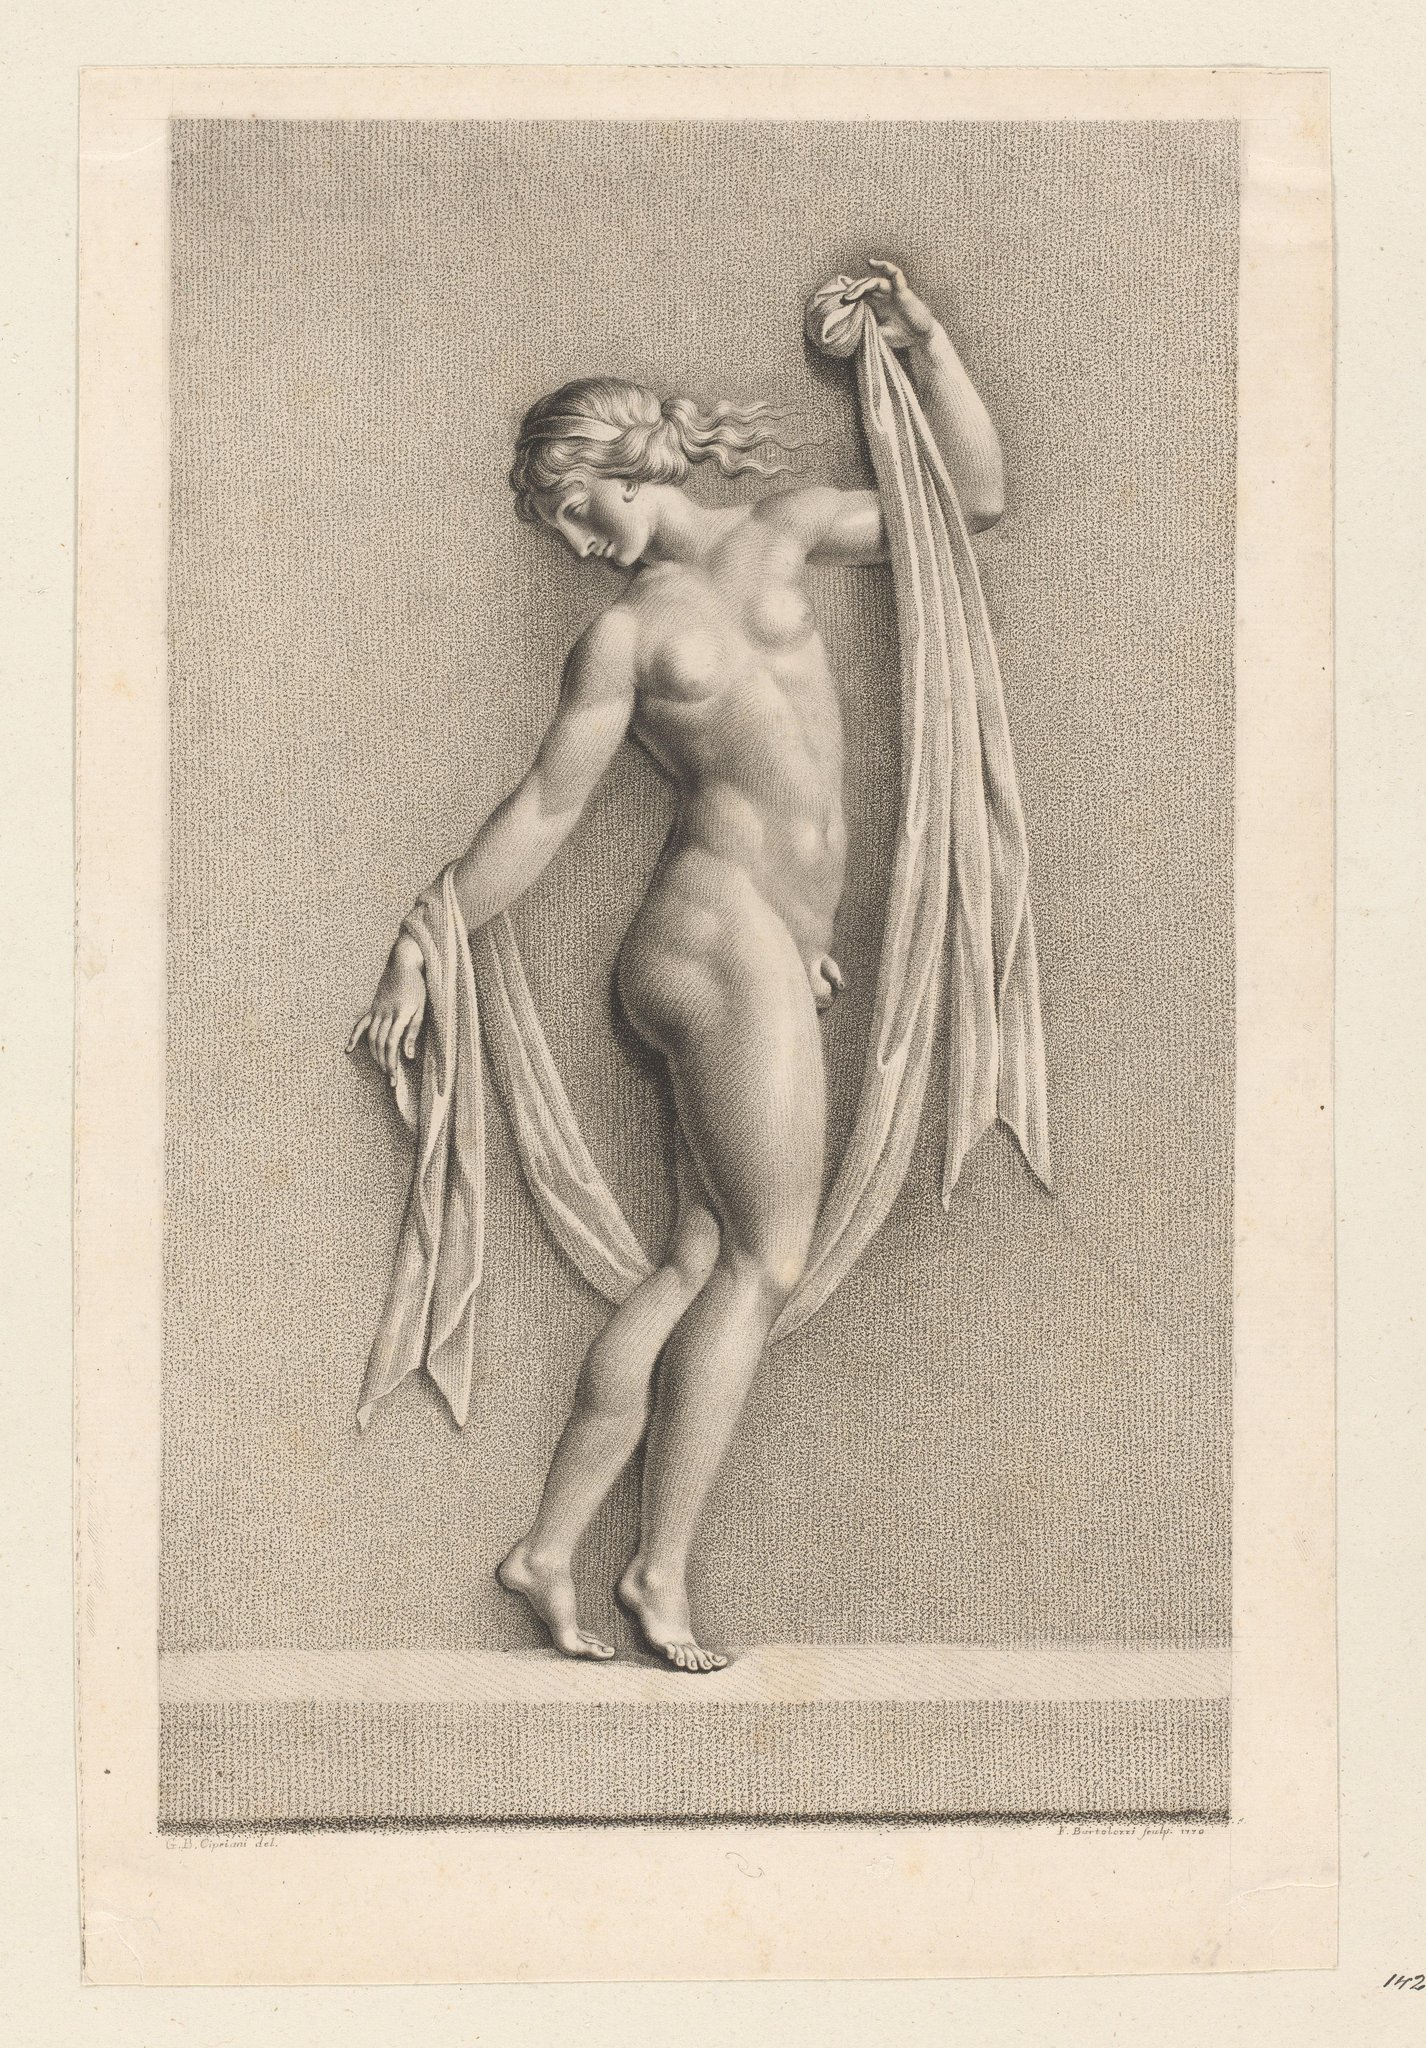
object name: print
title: Dansende Hermaphroditus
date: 1770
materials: paper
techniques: etching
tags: (story of) hermaphroditus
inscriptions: collector's mark: Lugt 2228, collector's mark: Lugt 2760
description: Dansende naakte Hermaphroditus met kleed in de hand.